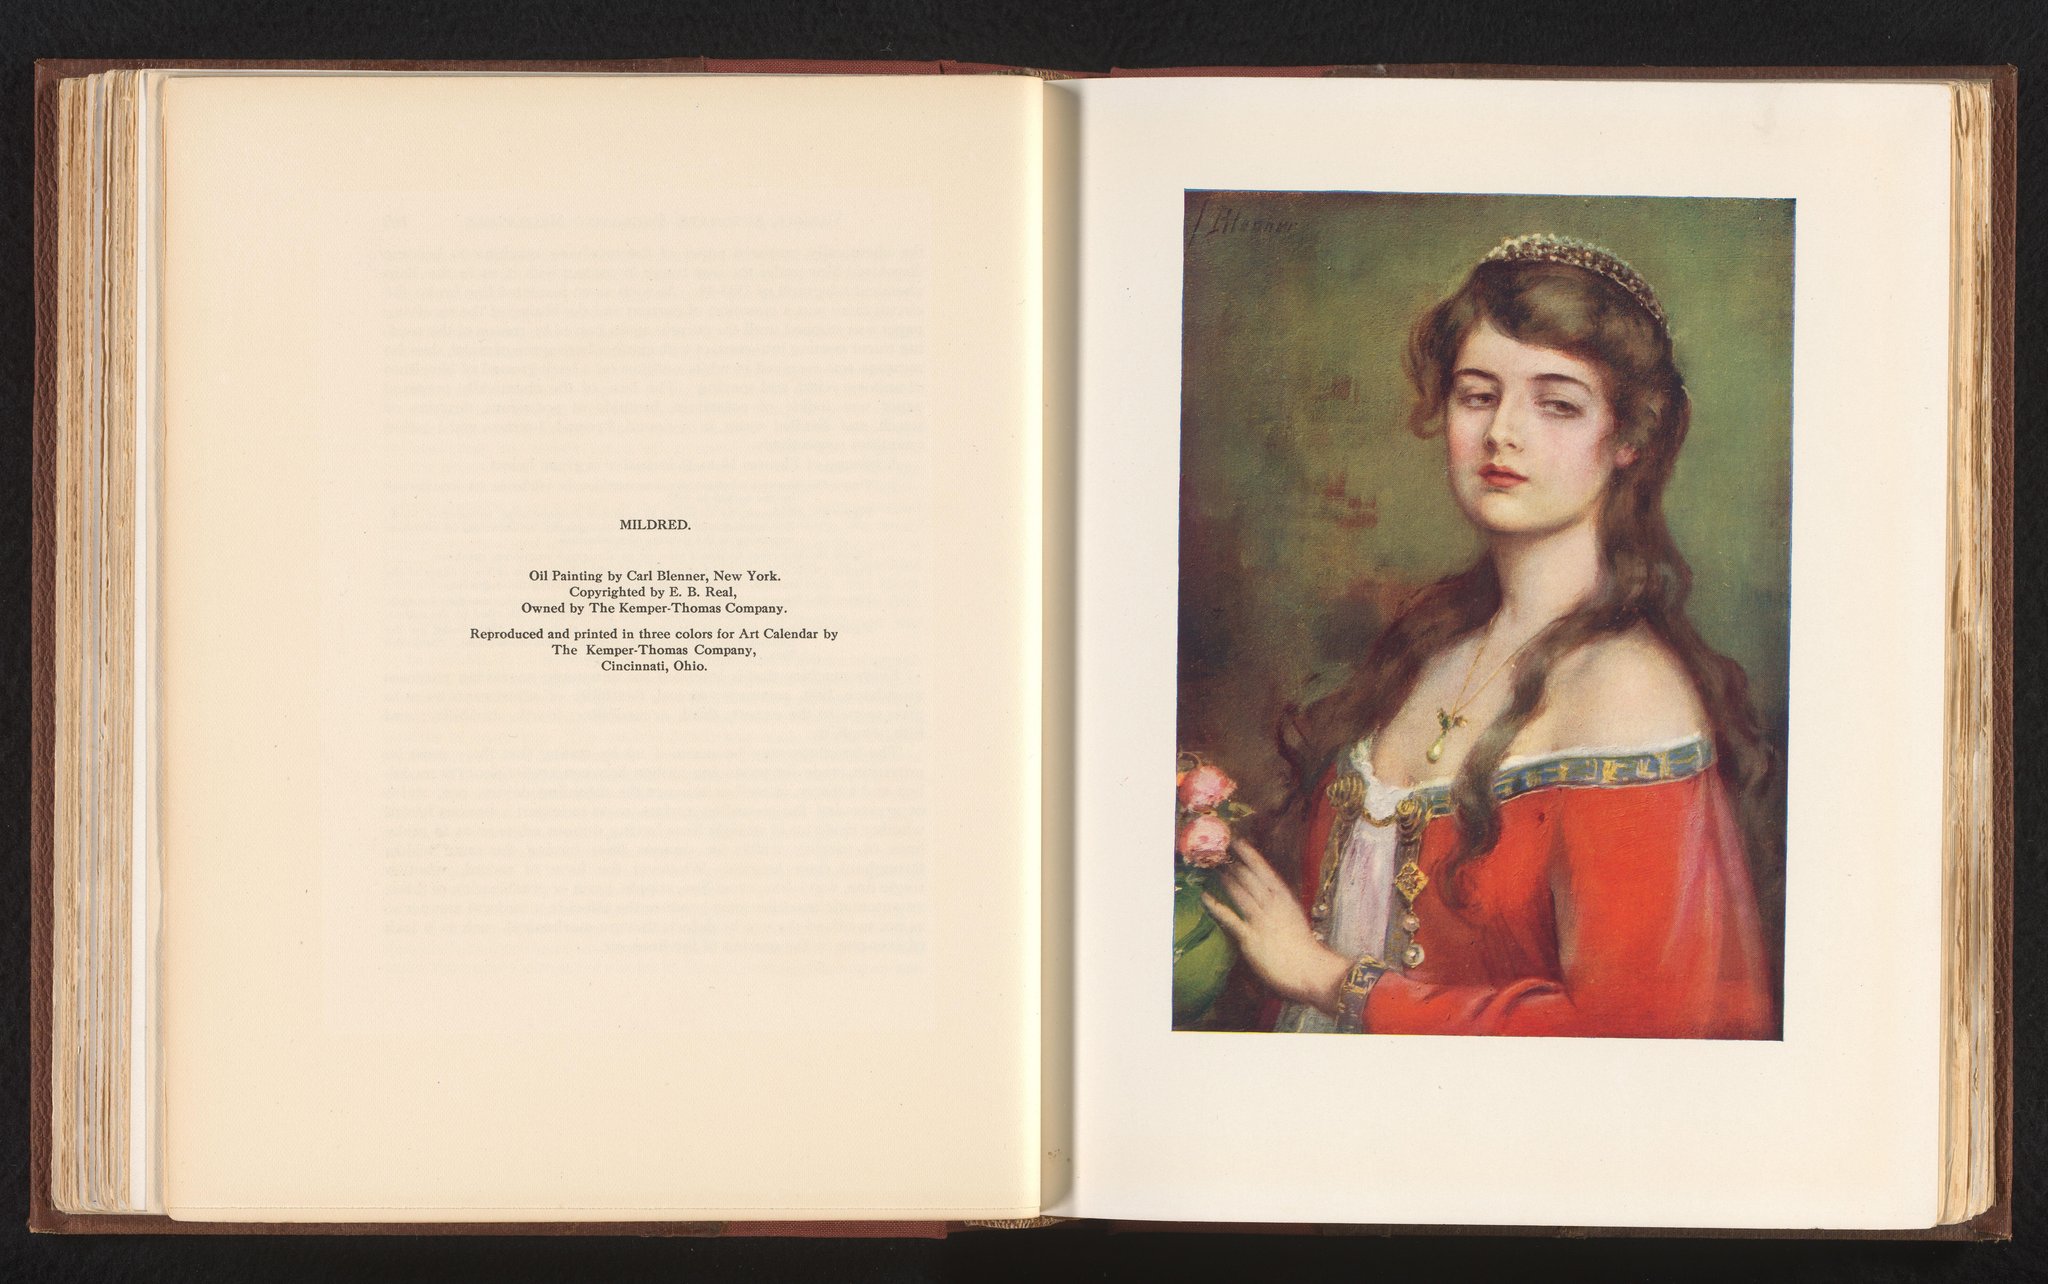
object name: photomechanical print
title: Reproductie van een schilderij met een portret van een vrouw aangeduid als 'Mildred' door Carle John Blenner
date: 1904-1909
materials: paper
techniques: three-color autotype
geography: cincinnati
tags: adolescent, young woman, maiden, historical persons not known by name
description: Prent op tweede ongenummerde pagina na pagina 165.